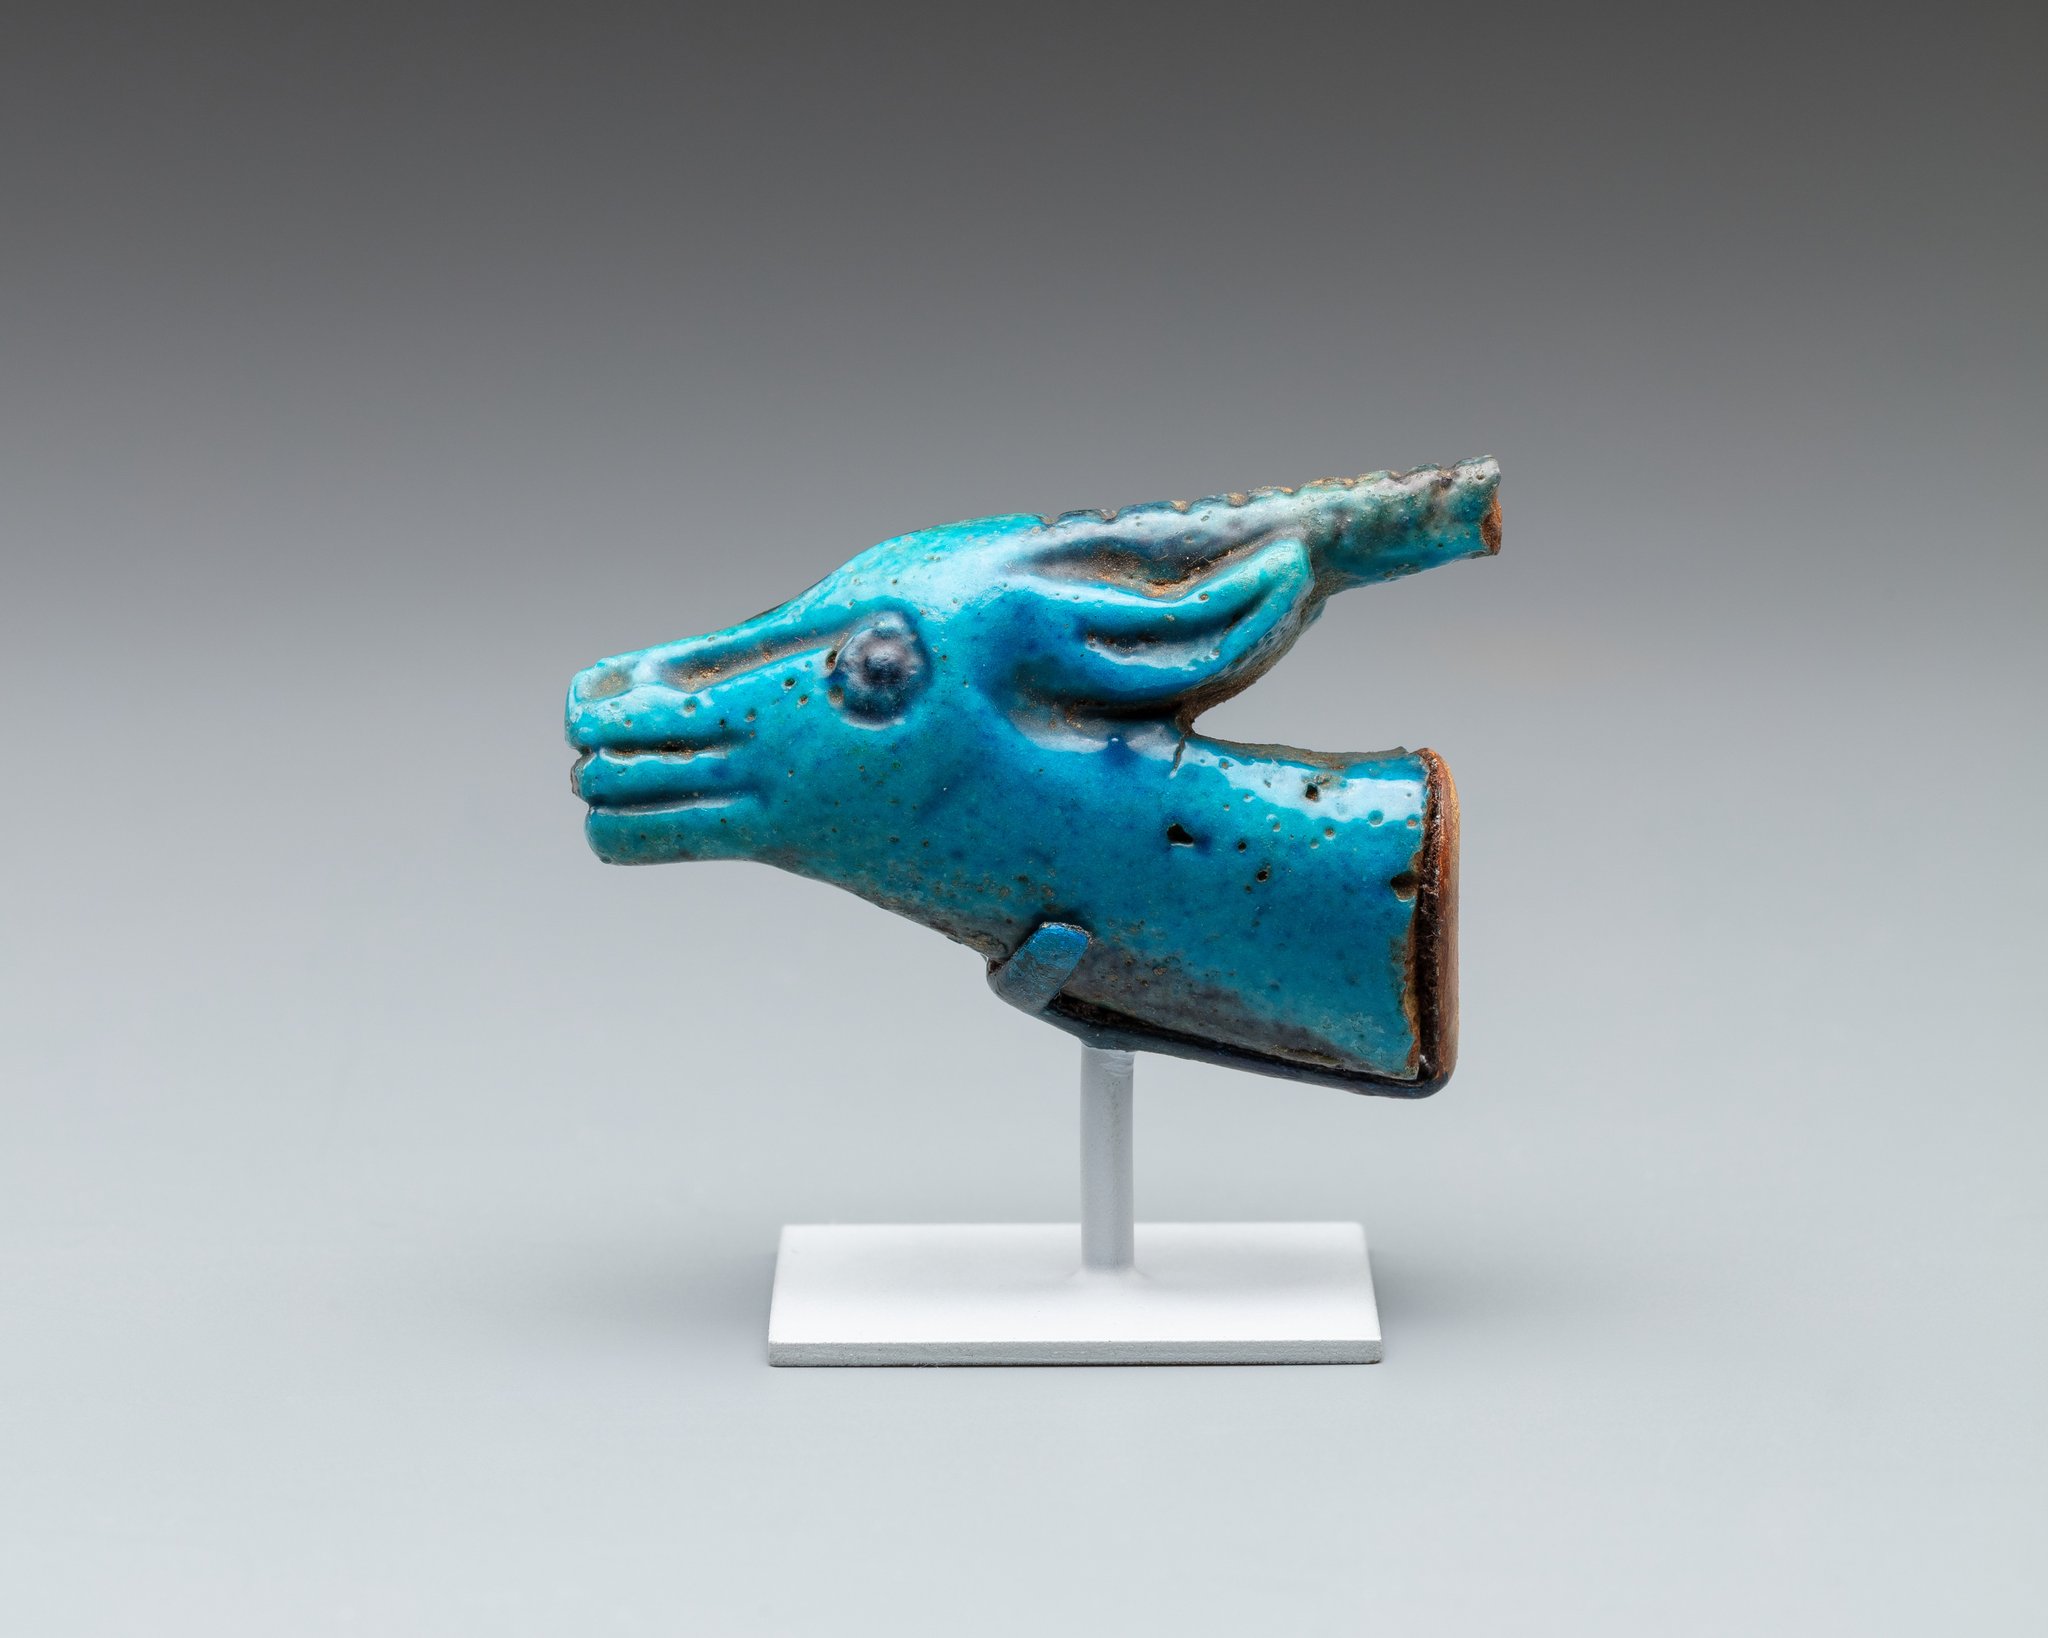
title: Fragmentary Head of an Oryx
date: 1550-664 BCE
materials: faience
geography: egypt